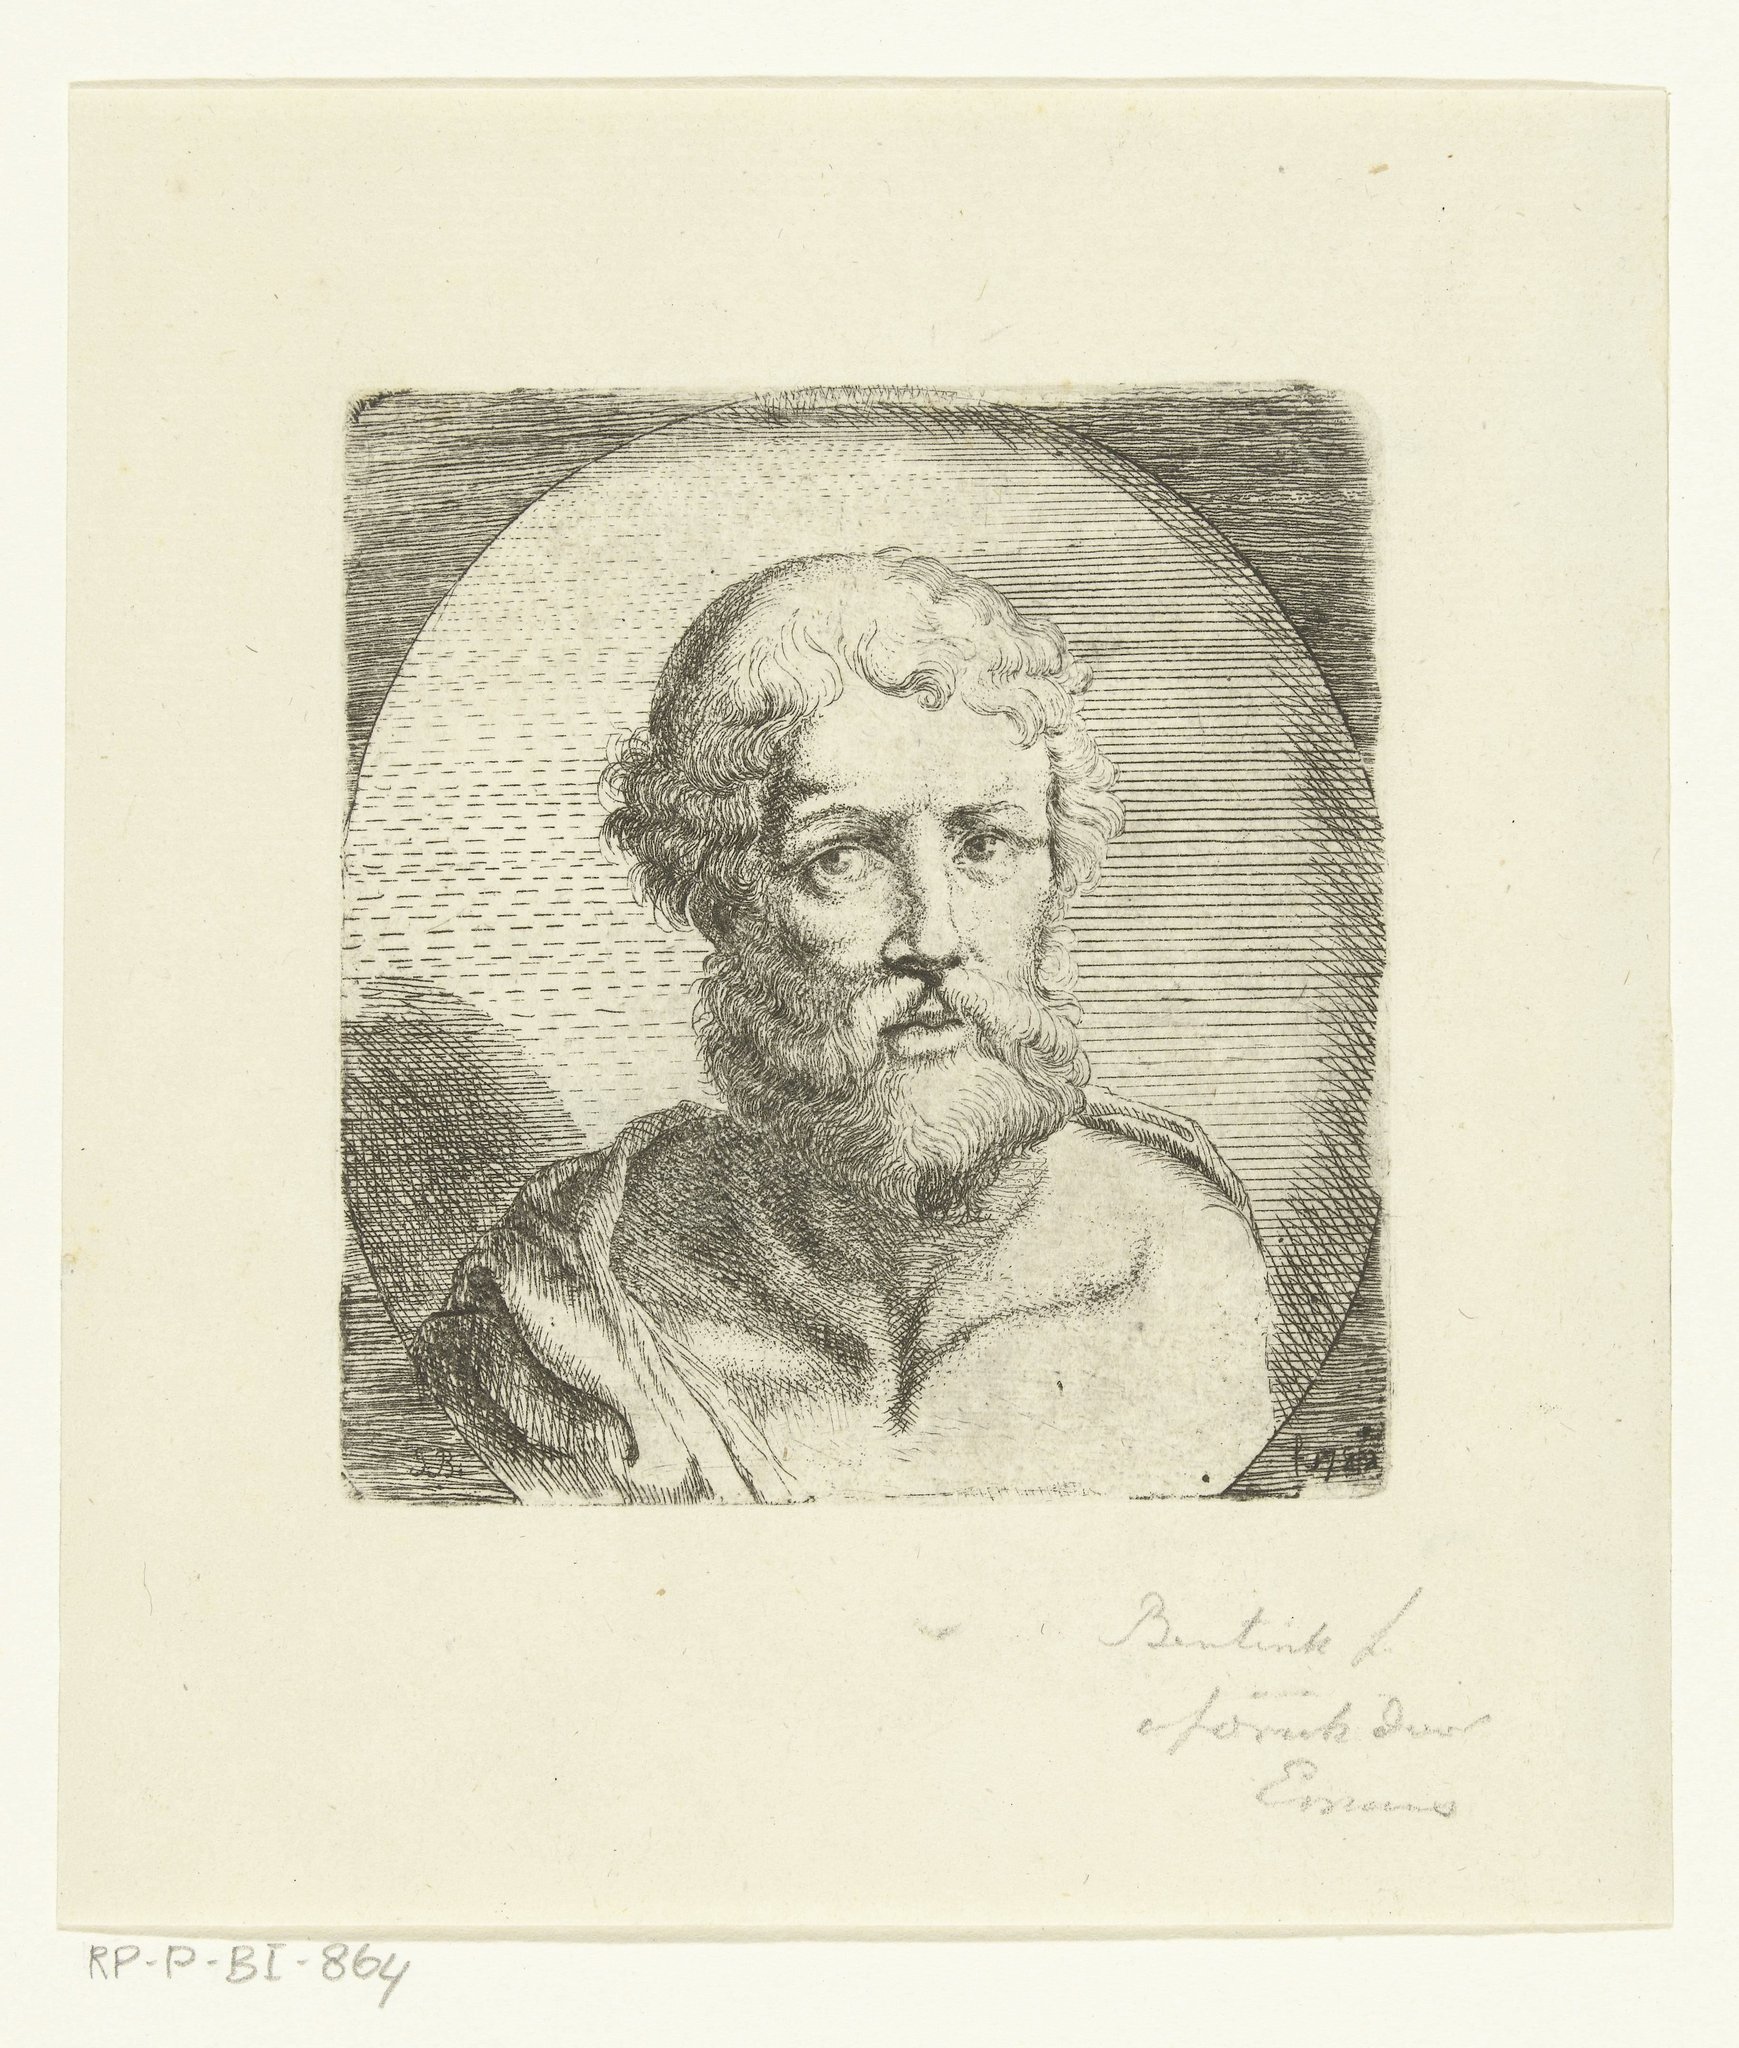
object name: print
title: Hoofd van onbekende man met baard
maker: jean charles bentinck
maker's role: draughtsman, print maker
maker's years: 1763-1833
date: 1773-1833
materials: paper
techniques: etching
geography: netherlands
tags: beard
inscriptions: collector's mark: Lugt 2228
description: Volgens een opschrift van vroegere verzamelaar betreft het hier een late druk van een koperplaat in het bezit van Gerardus Emaus de Micault.